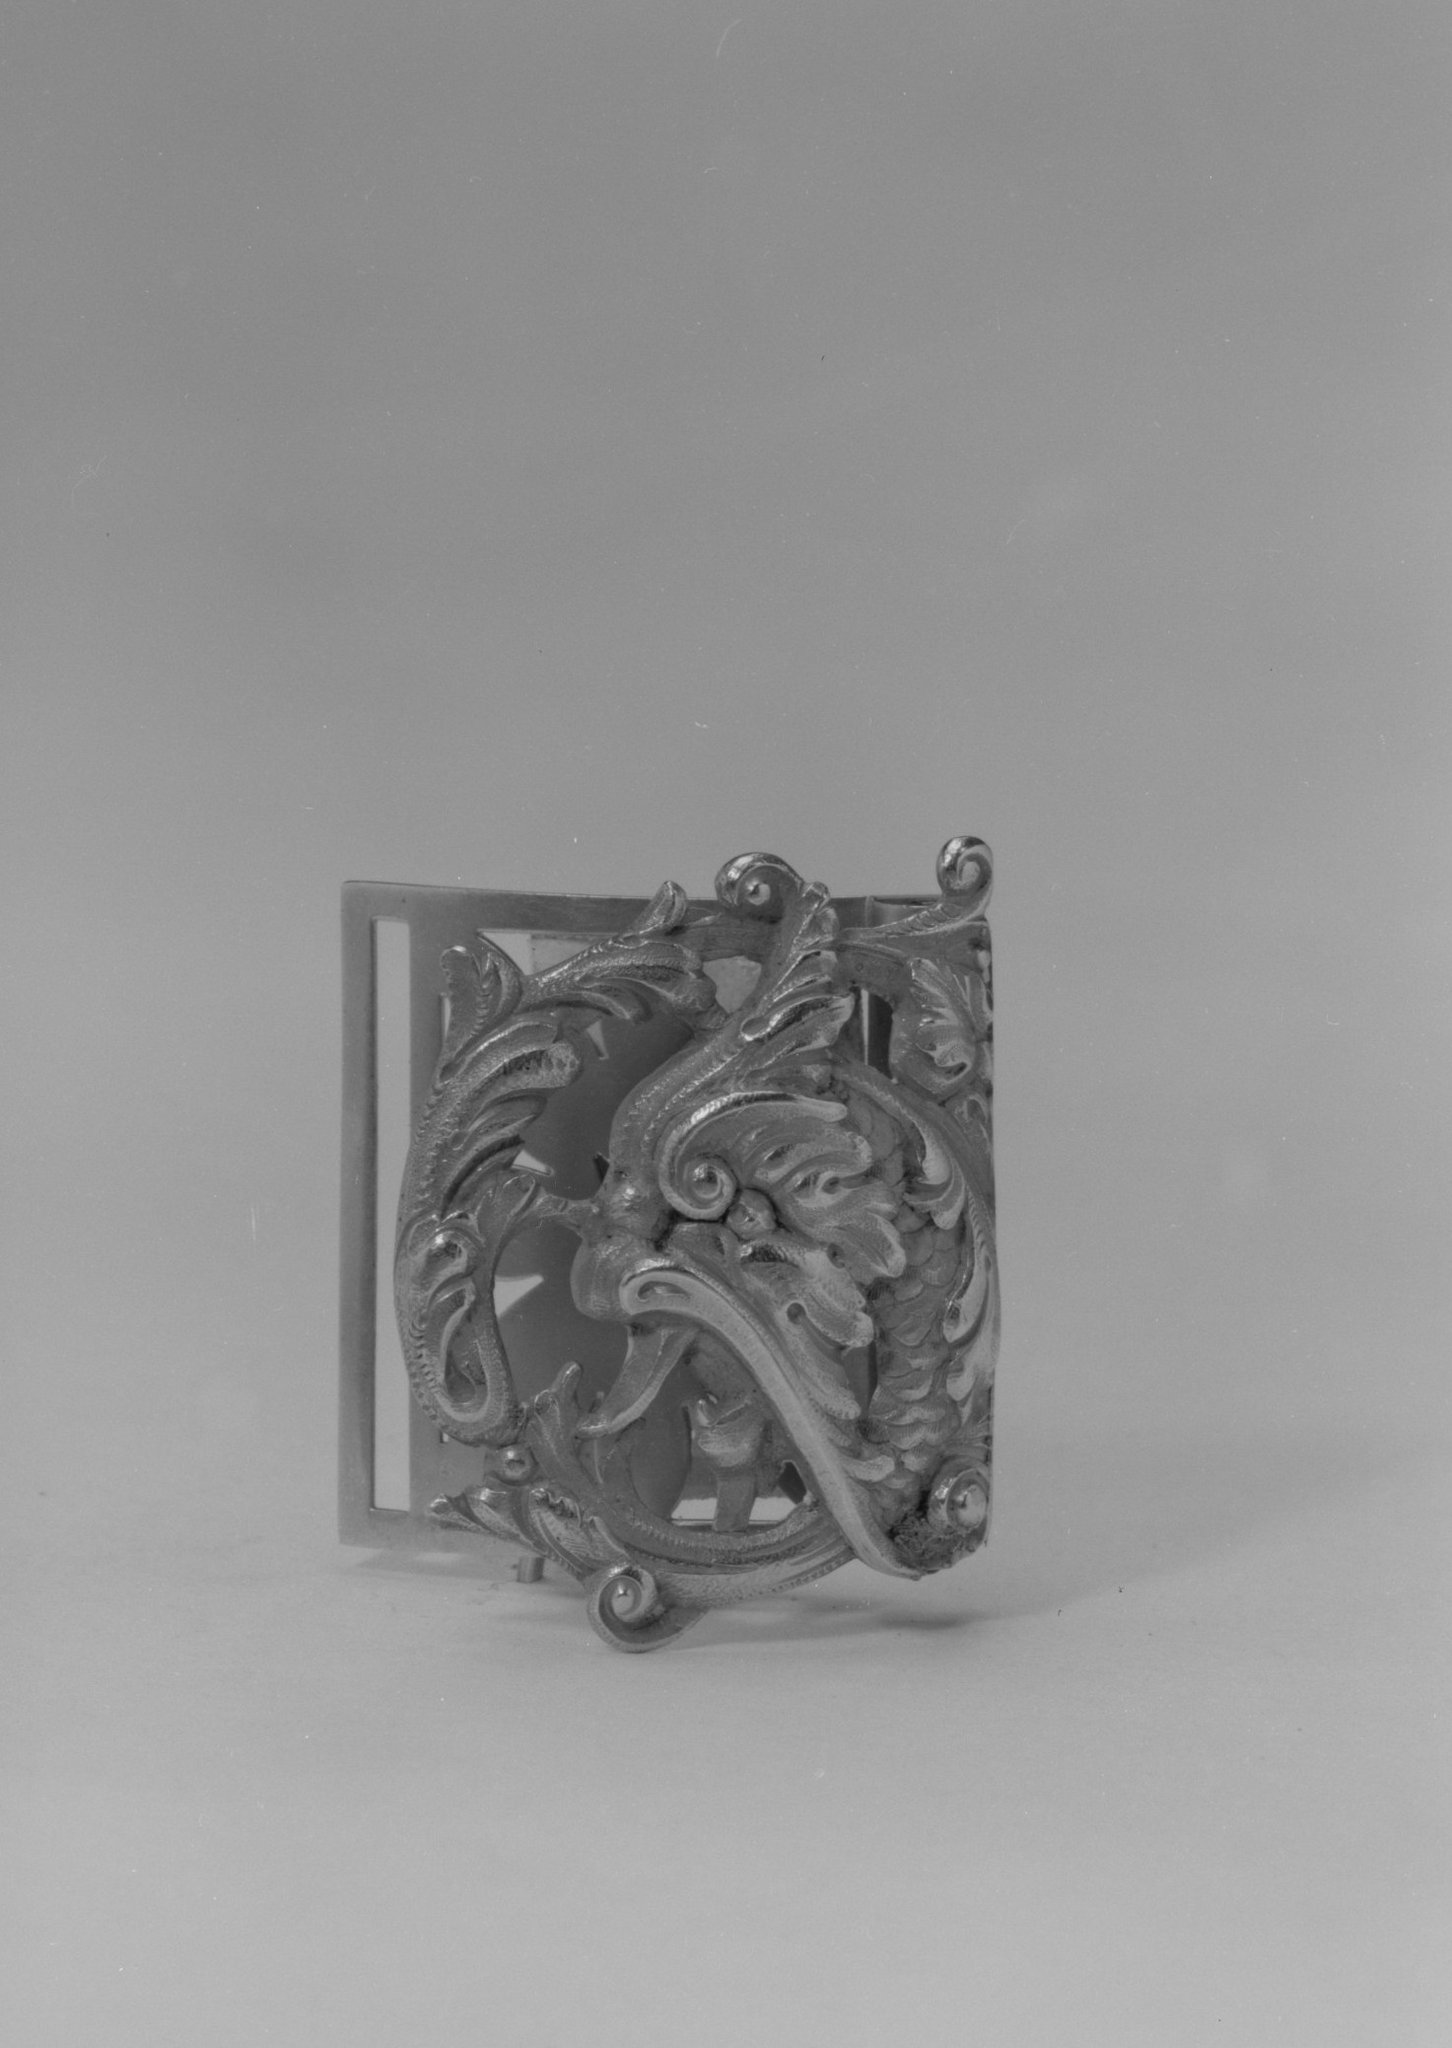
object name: buckle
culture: american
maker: theodore b. starr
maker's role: maker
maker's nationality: american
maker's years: 1837-1907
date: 1900-1924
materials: gold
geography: united states